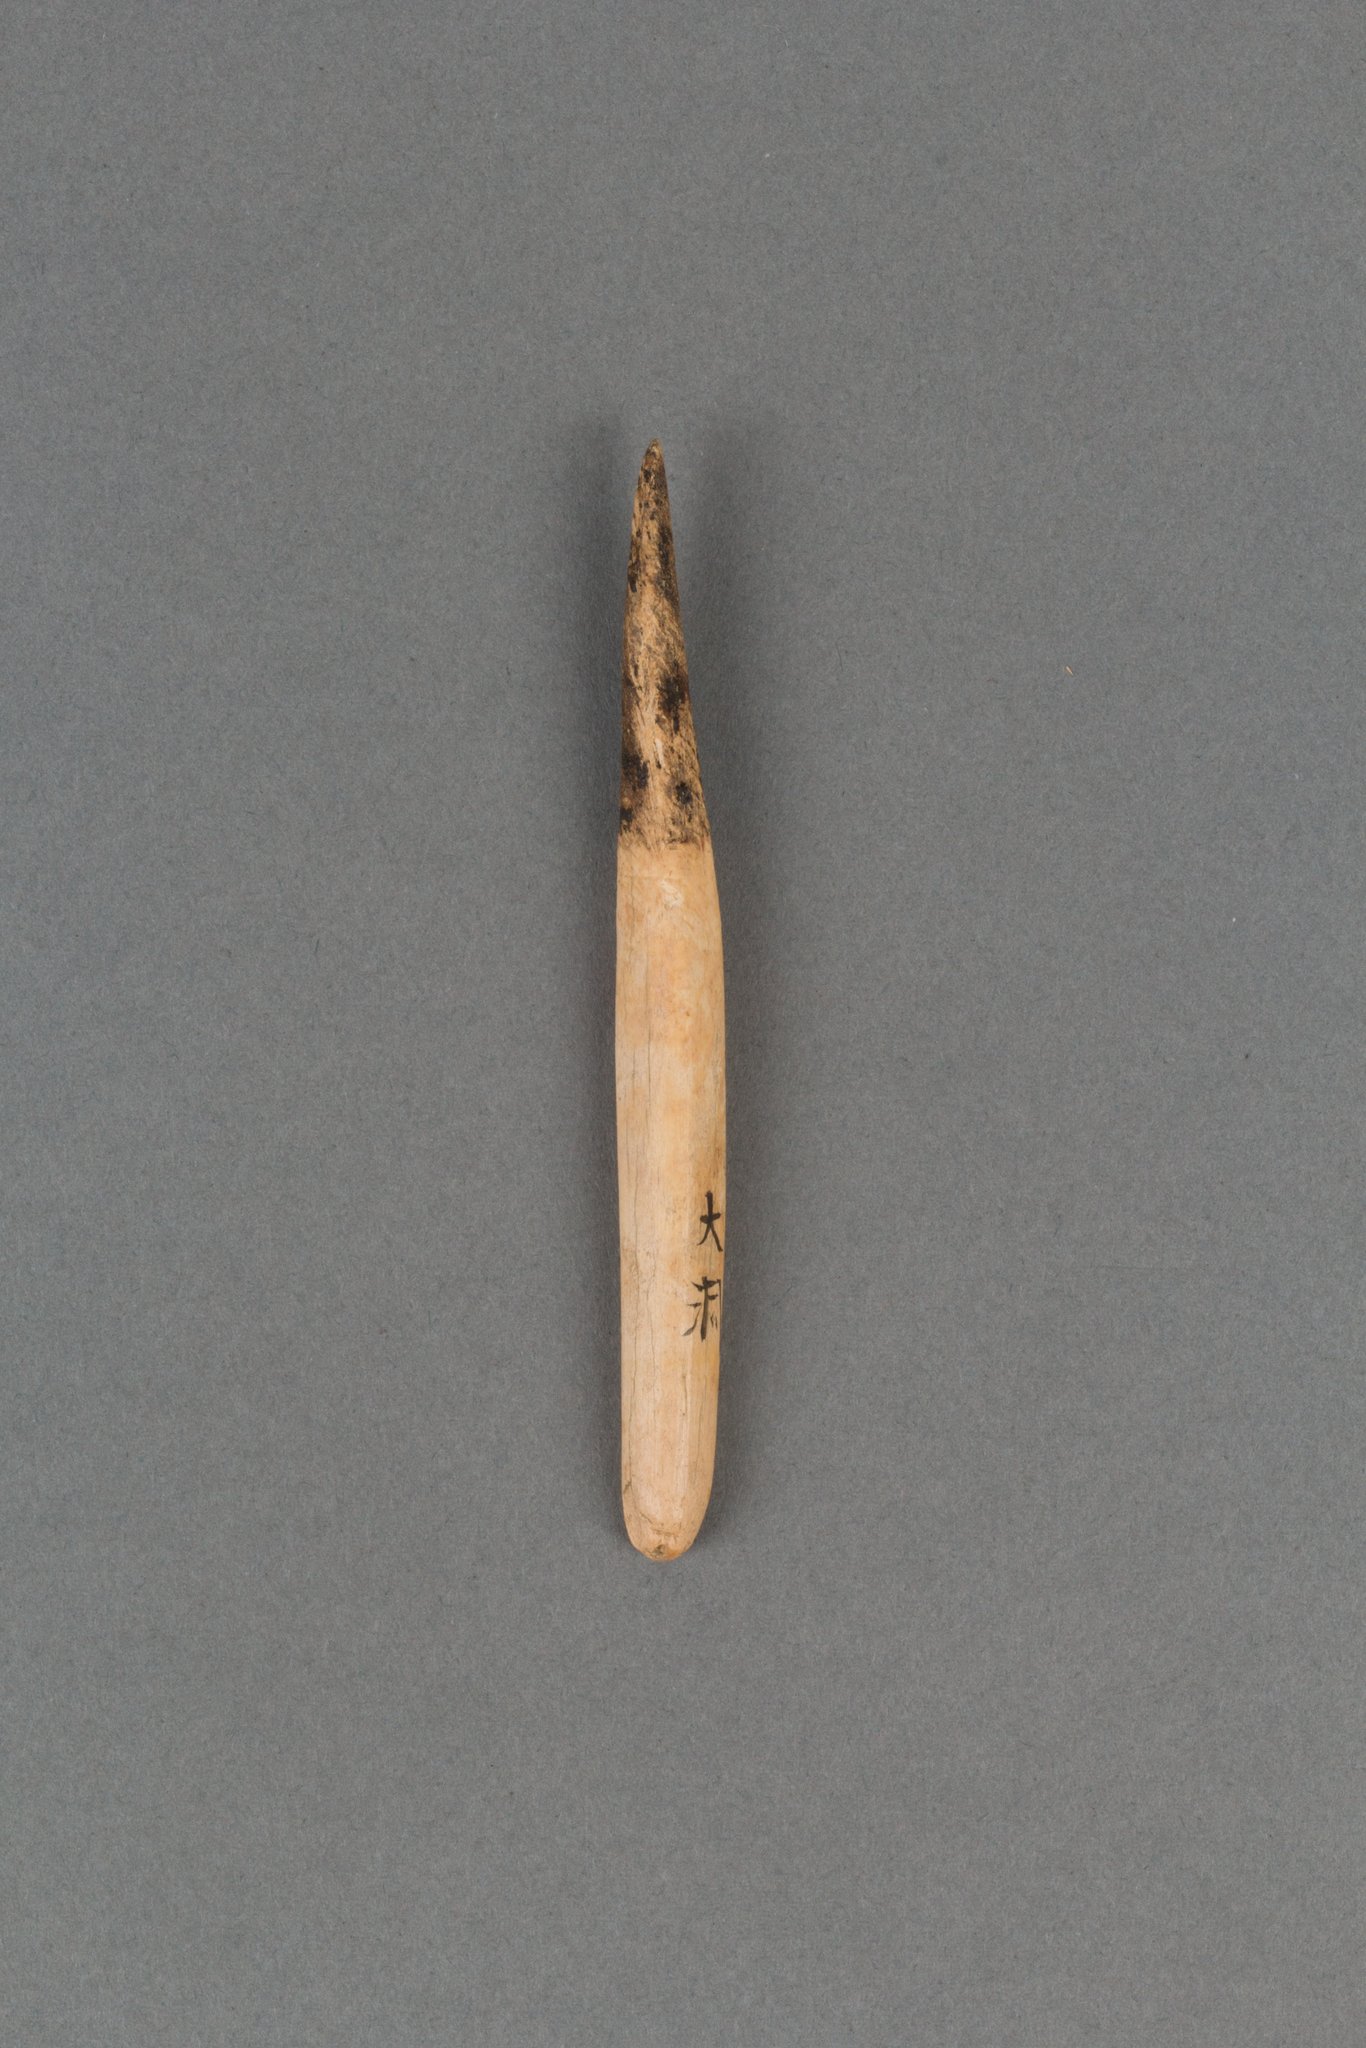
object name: harpoon head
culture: japanese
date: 1200-200 BCE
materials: bone